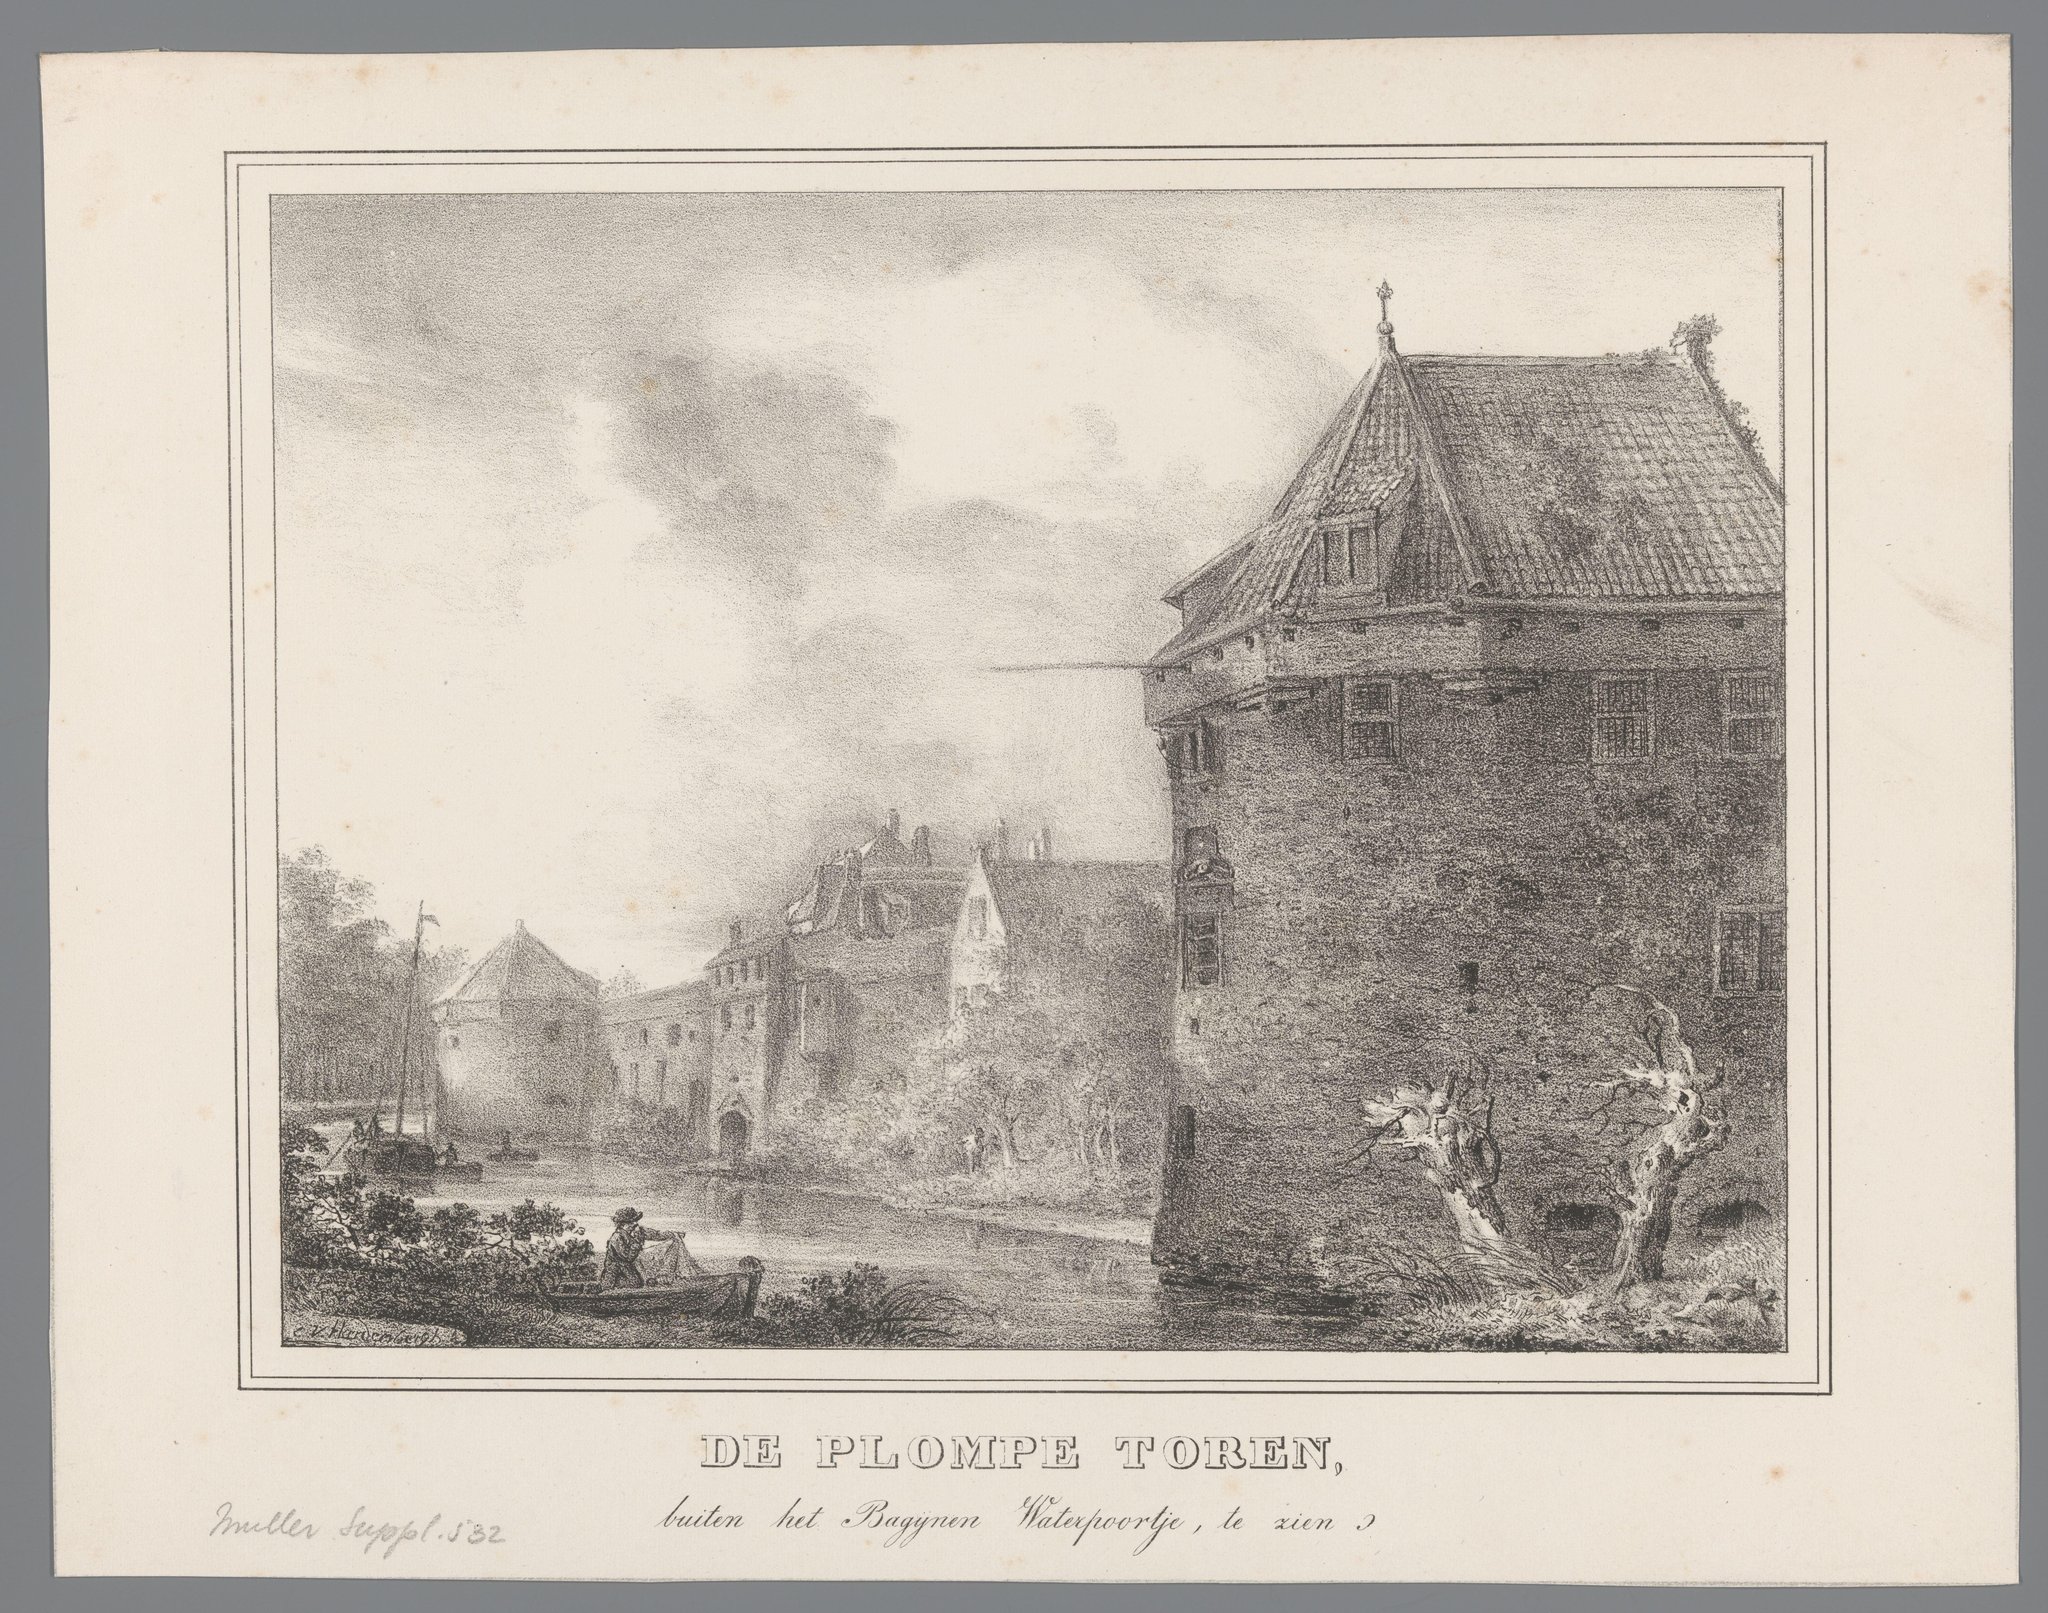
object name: print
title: Afbeeldingen van gezichten te of bij Utrecht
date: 1809-1843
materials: paper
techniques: lithograph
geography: utrecht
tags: towers ~ fortified city, fisherman, utrecht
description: Links van de toren loopt een gracht. Een visser is in de weer met zijn netten.